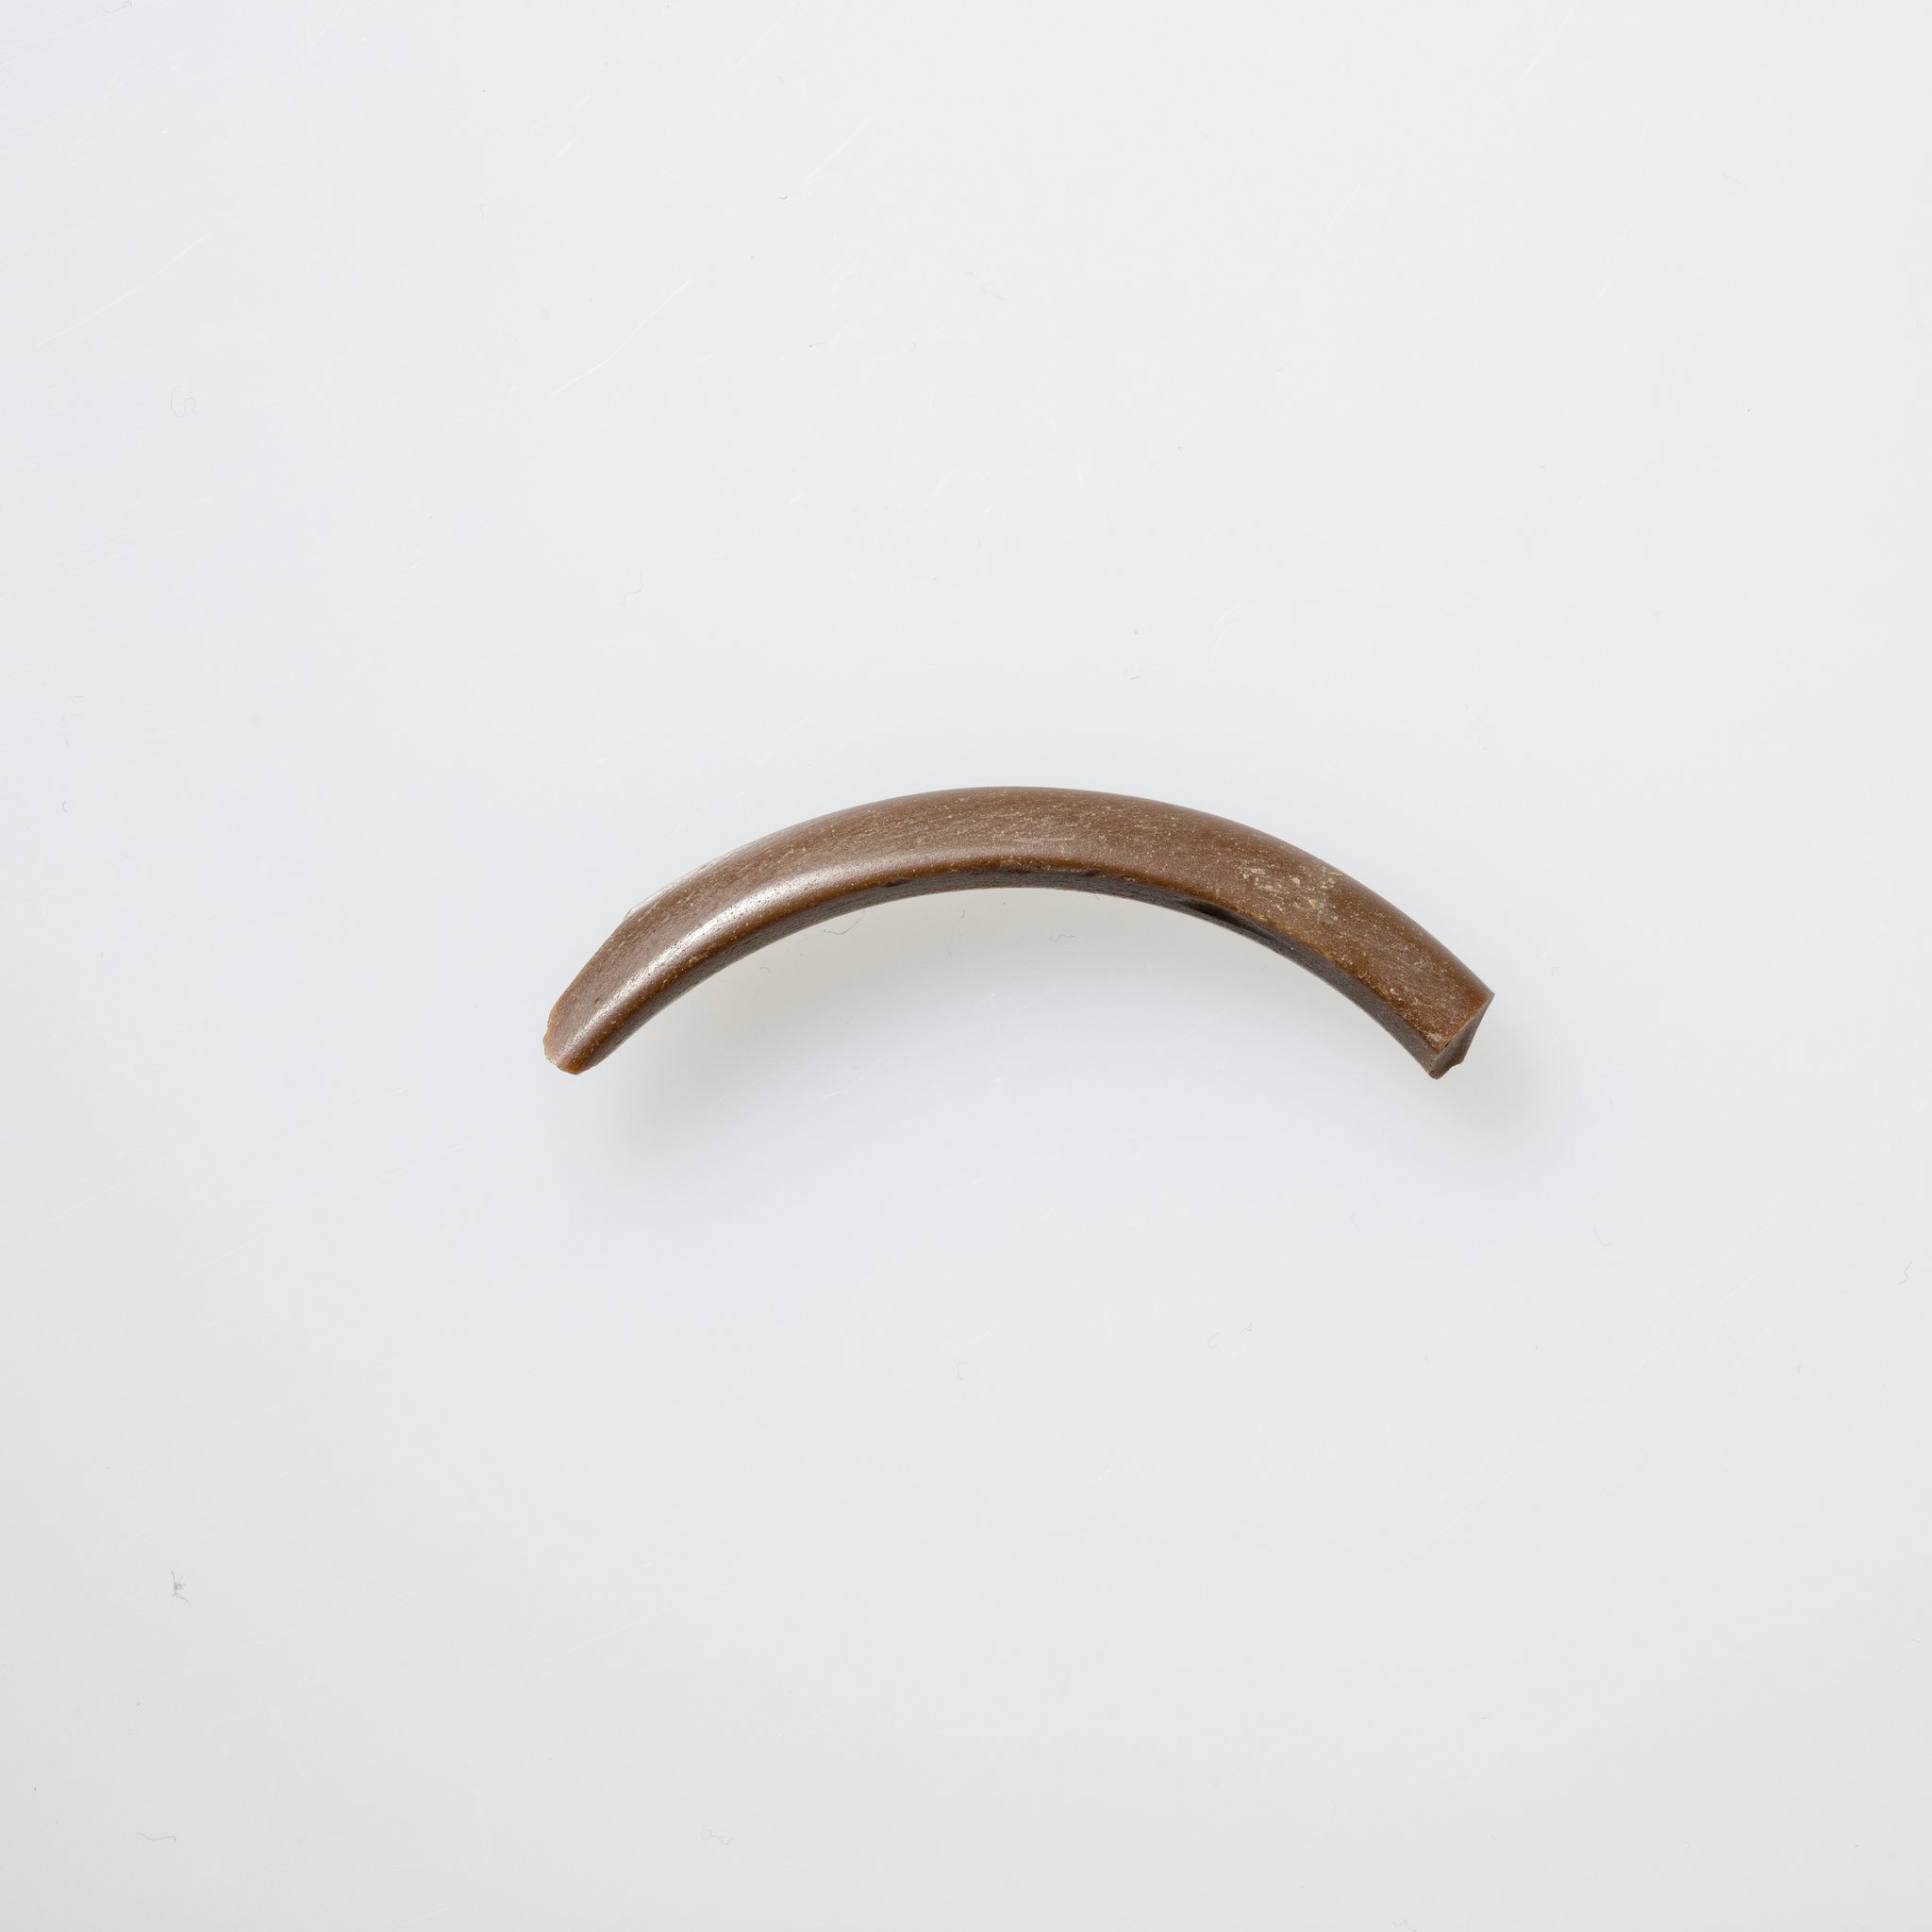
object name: bracelet, bangle, fragment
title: Bracelet (Bangle) Fragment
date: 3100-2649 BCE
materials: stone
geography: egypt